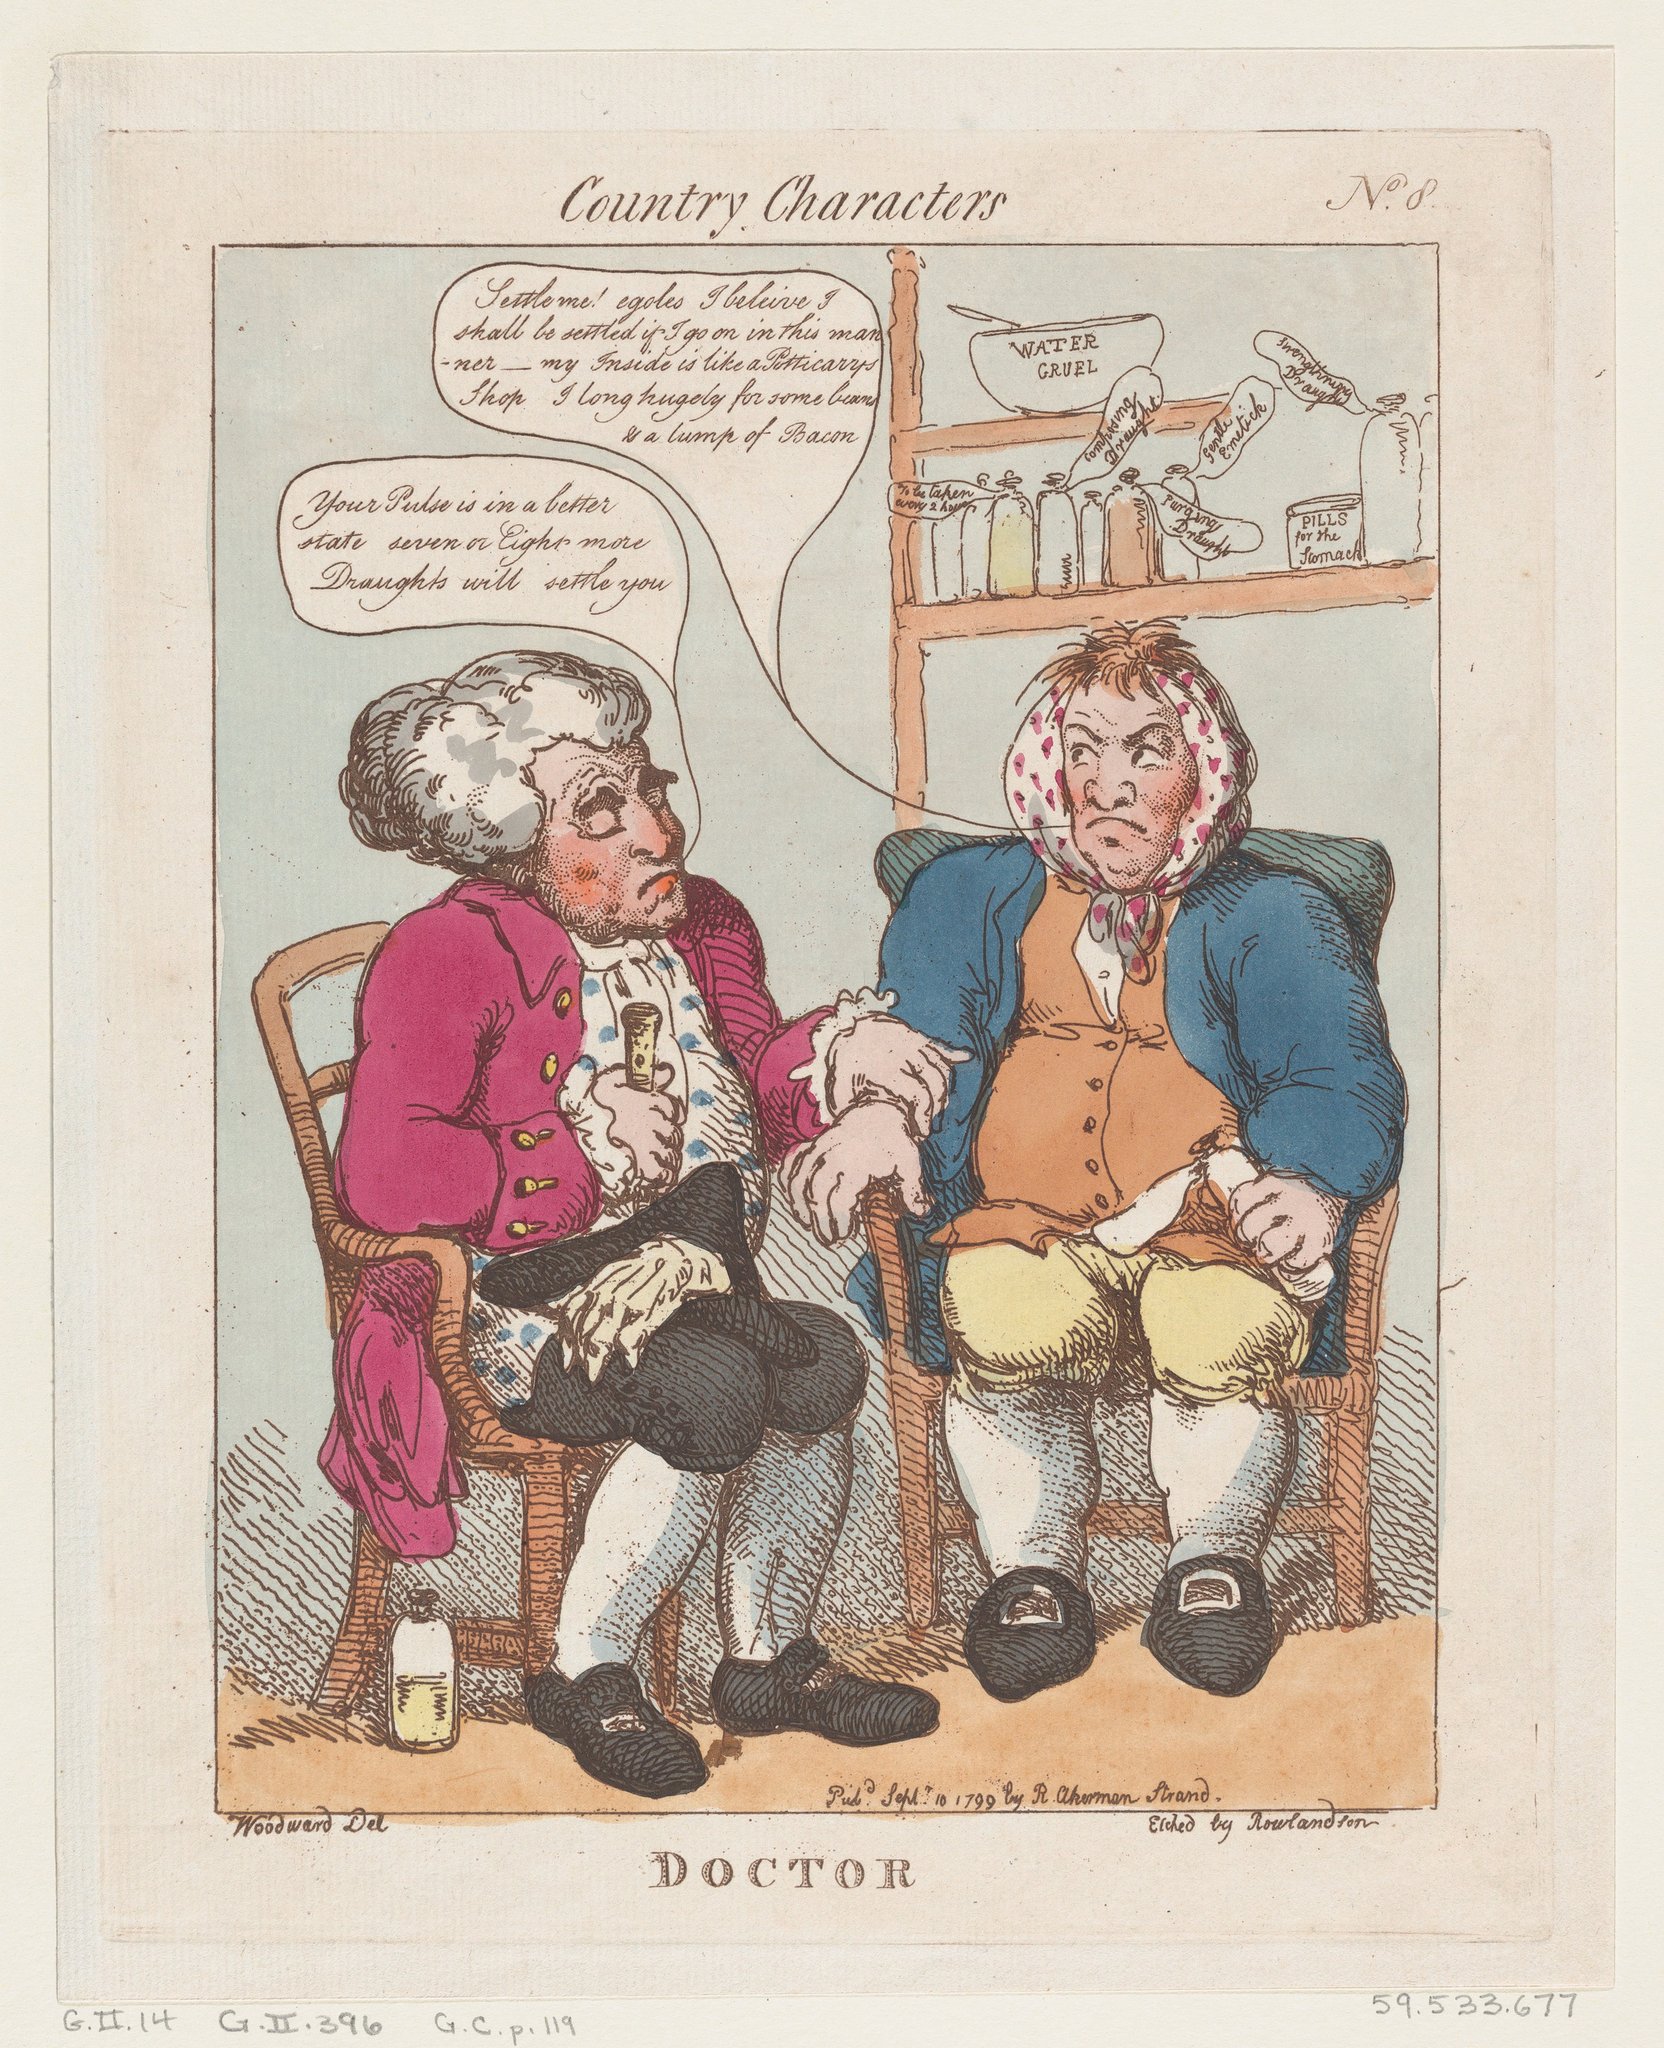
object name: print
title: Doctor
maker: thomas rowlandson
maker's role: artist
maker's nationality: british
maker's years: 1757-1827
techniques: etching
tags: men